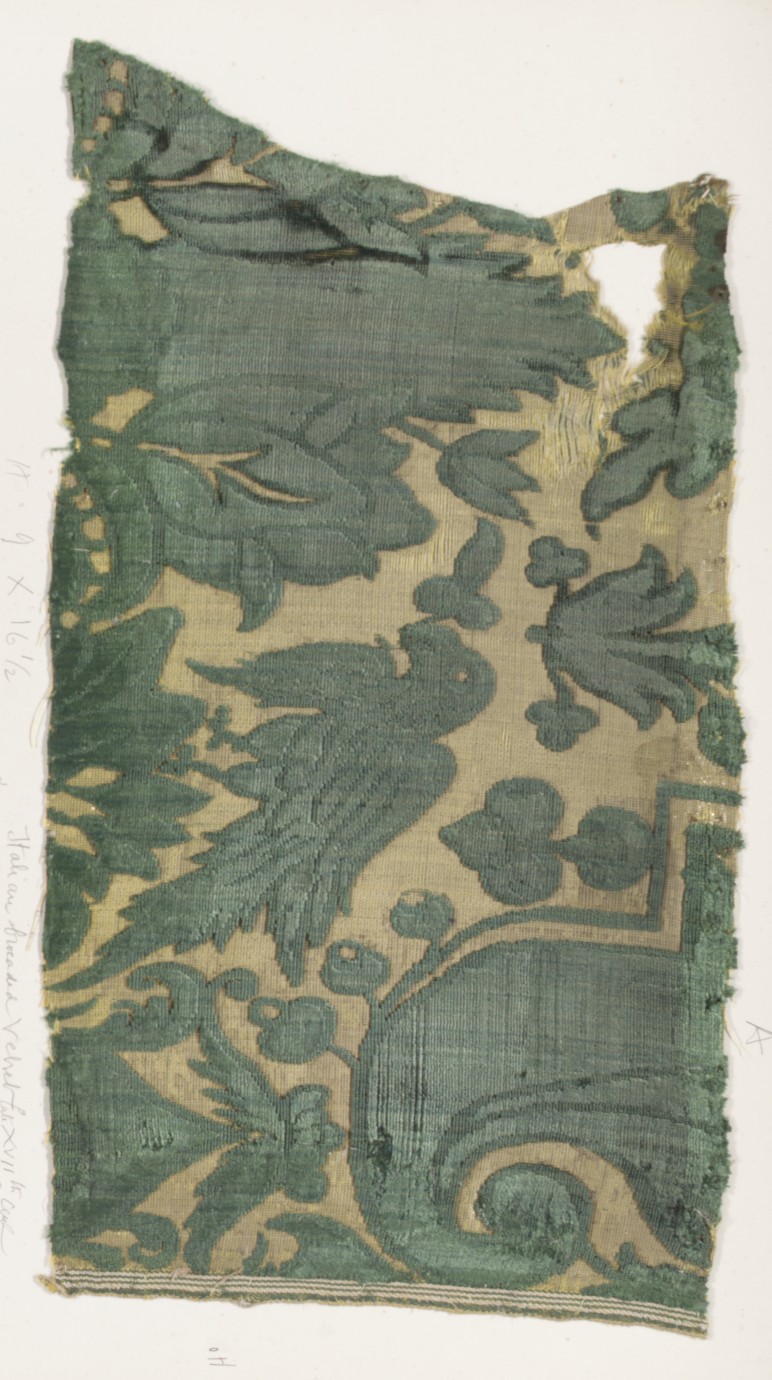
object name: fragment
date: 1667-1700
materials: metal thread, silk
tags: birds,leaves